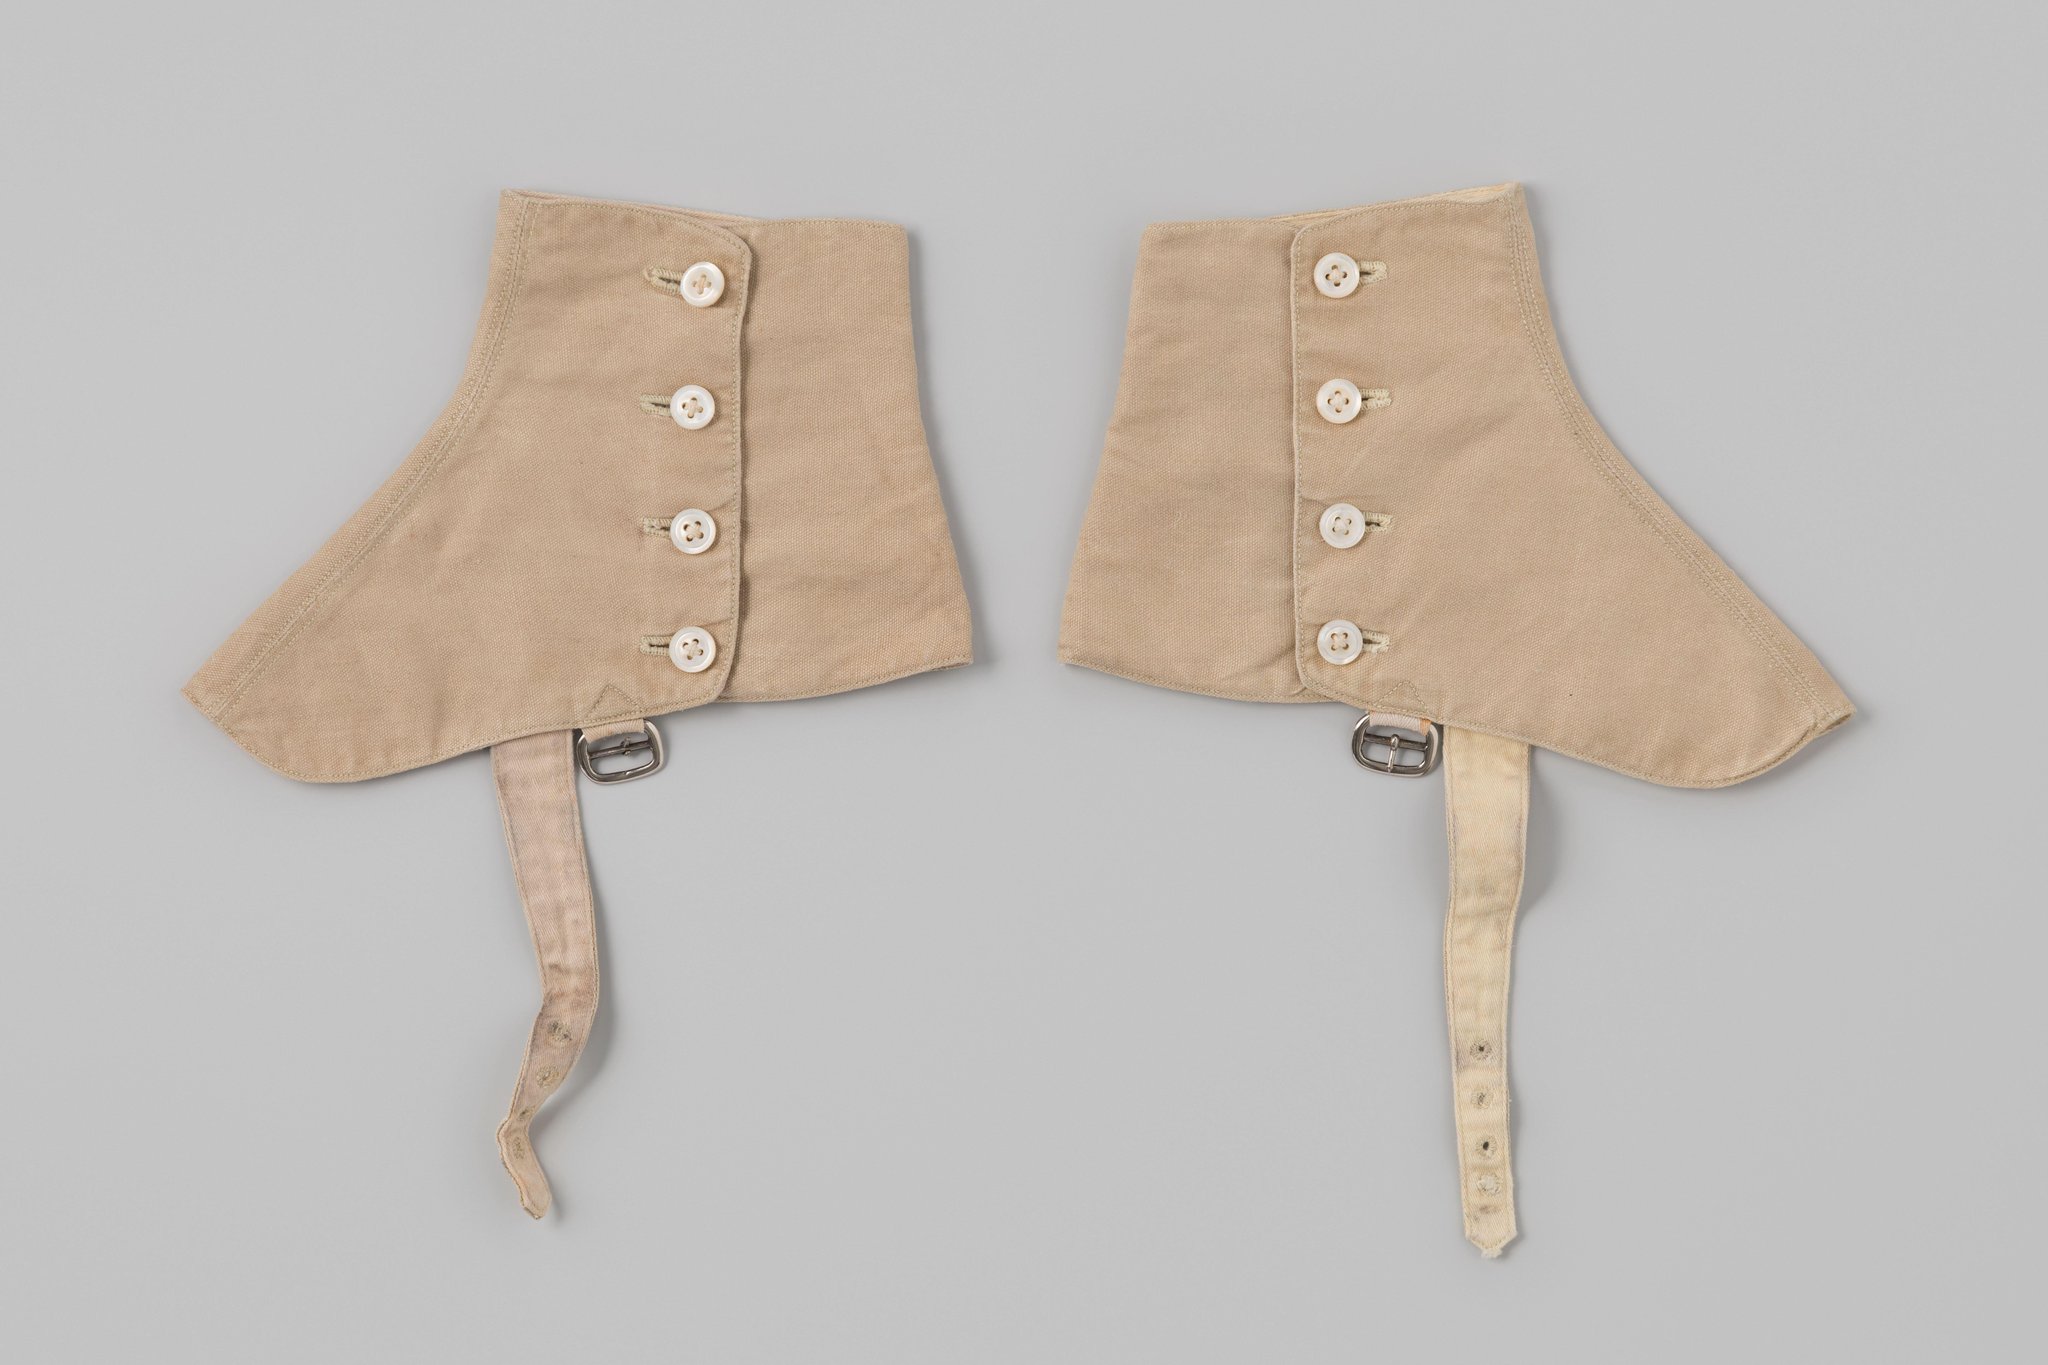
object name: clothing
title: Slobkous van beige linnenkatoen, met vier parelmoeren knopen en linnen riem met gesp onder de voet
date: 1900-1930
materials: cotton, metal, mother of pearl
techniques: weave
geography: england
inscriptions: label: ‘'The Diamond Garter. Reg'd. Made in England'’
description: Paar slobkousen van beige linnen, met voering. Vier parelmoeren knoopjes en een zoolriempje met gespje, souspied. Adres: 'The Diamond Garter. Reg'd. Made in England'.